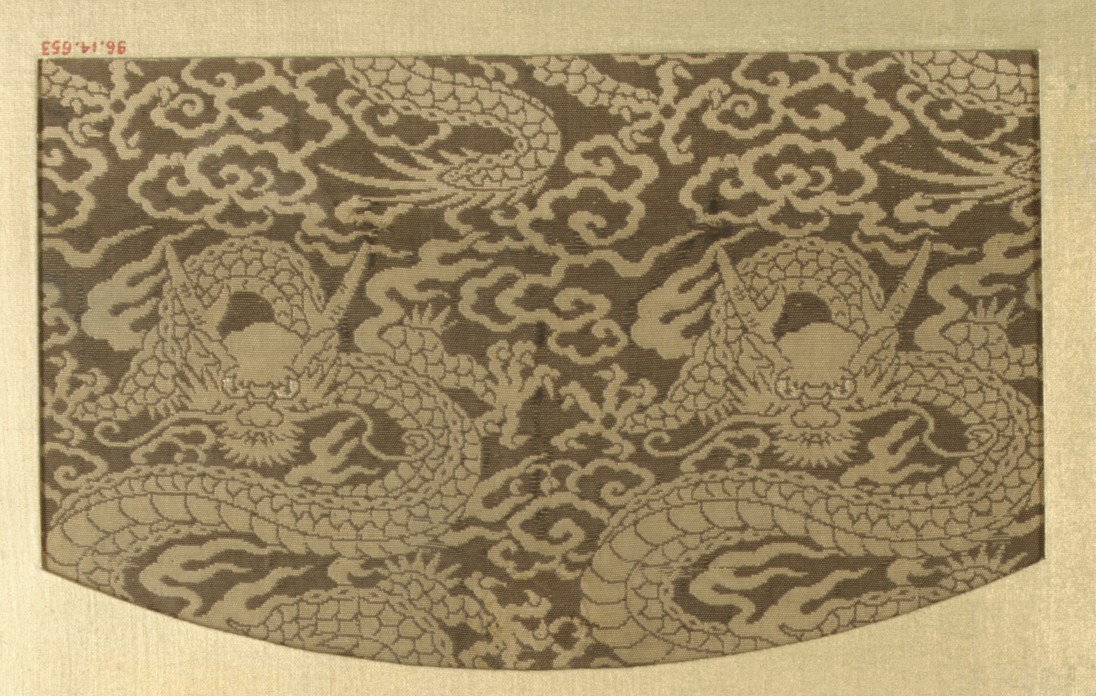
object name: piece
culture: japanese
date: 1701-1900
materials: silk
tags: dragons